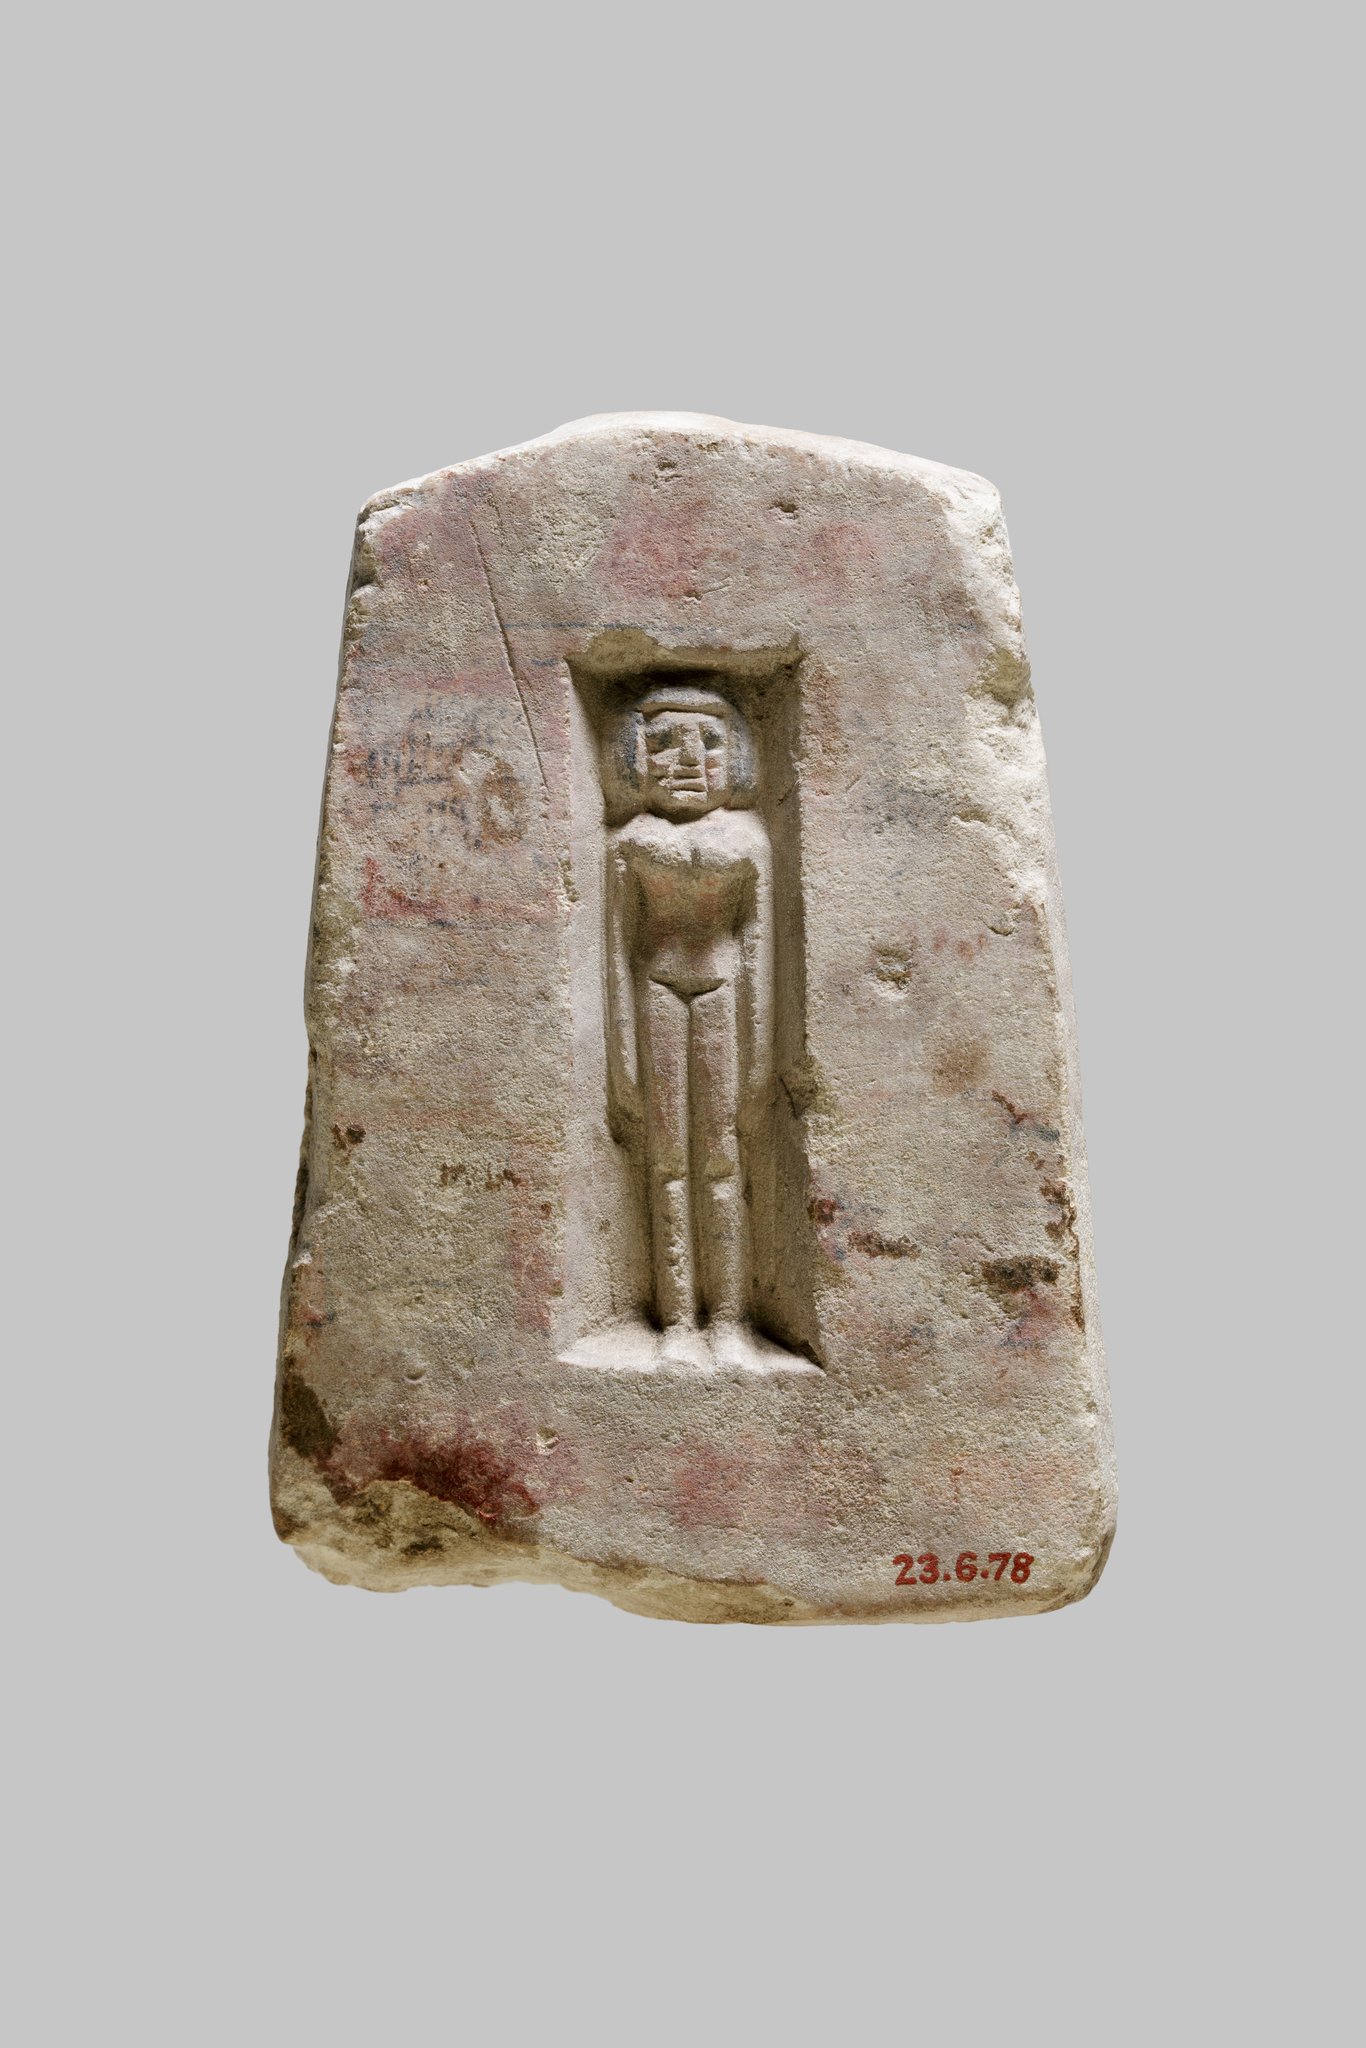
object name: stela, female figure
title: Plaque with nude female in a shrine niche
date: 600-275 BCE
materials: limestone, paint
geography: egypt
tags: female nudes